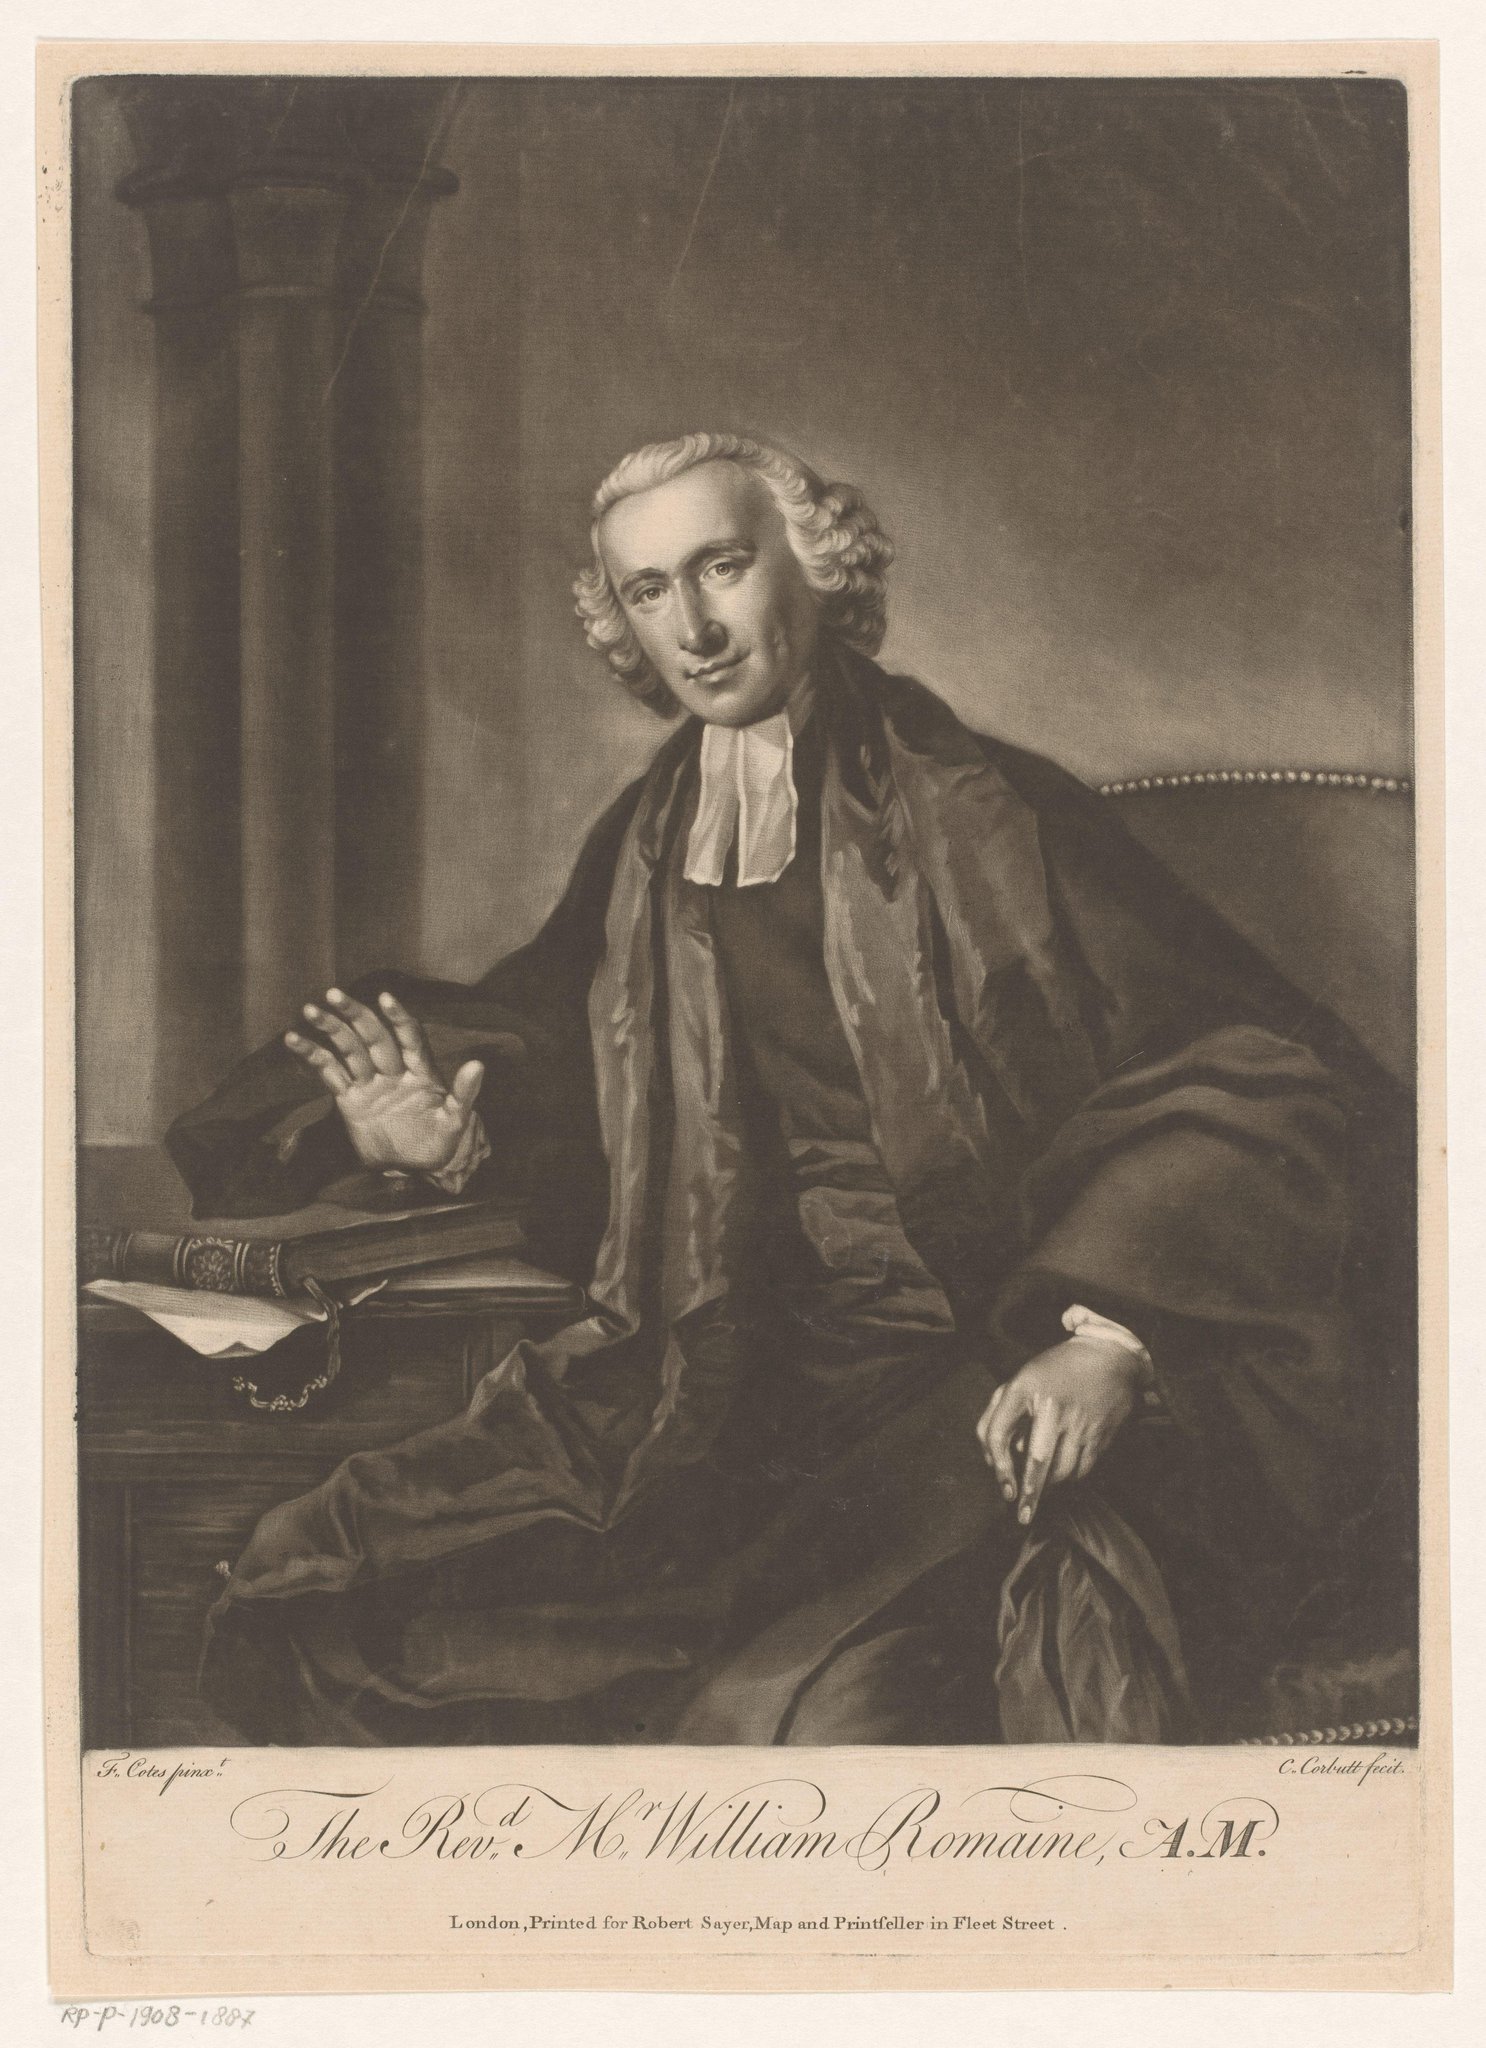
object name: print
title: Portret van William Romaine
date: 1746-1766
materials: paper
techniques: etching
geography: london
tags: historical persons, portrait of a writer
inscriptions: collector's mark: Lugt 2228